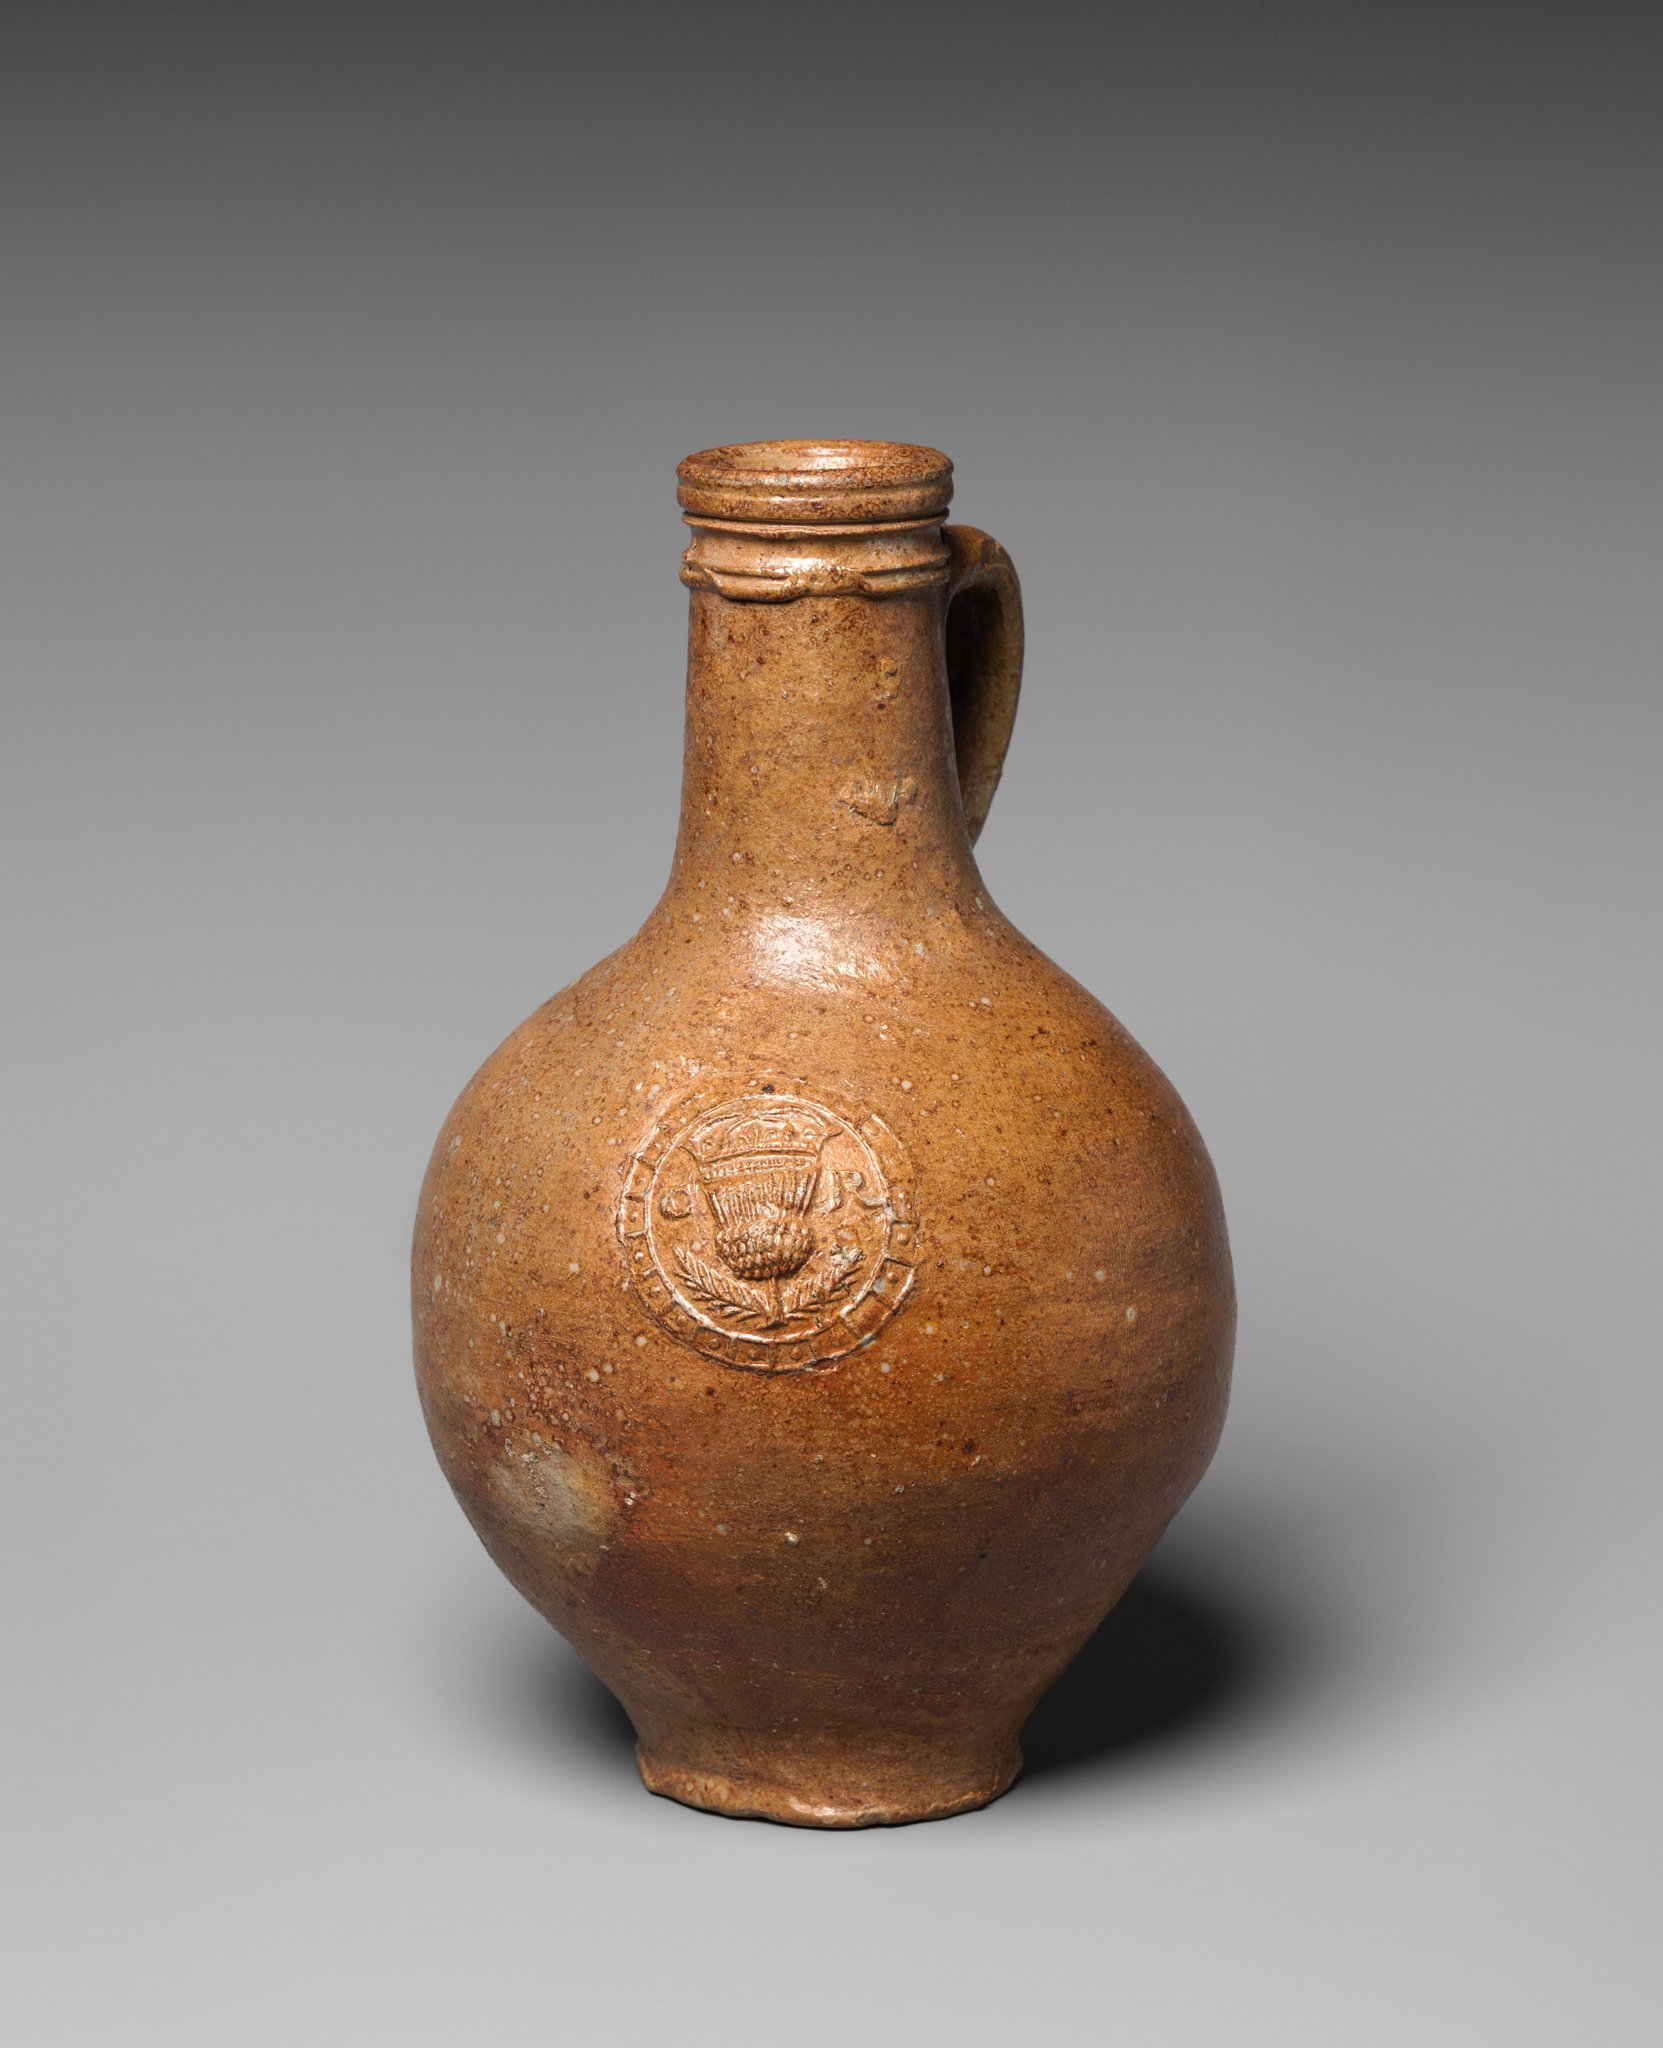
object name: bottle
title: Bottle with a thistle medallion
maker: john dwight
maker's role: maker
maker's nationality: british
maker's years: 1635-1703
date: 1675-1676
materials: stoneware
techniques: salt glaze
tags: coat of arms